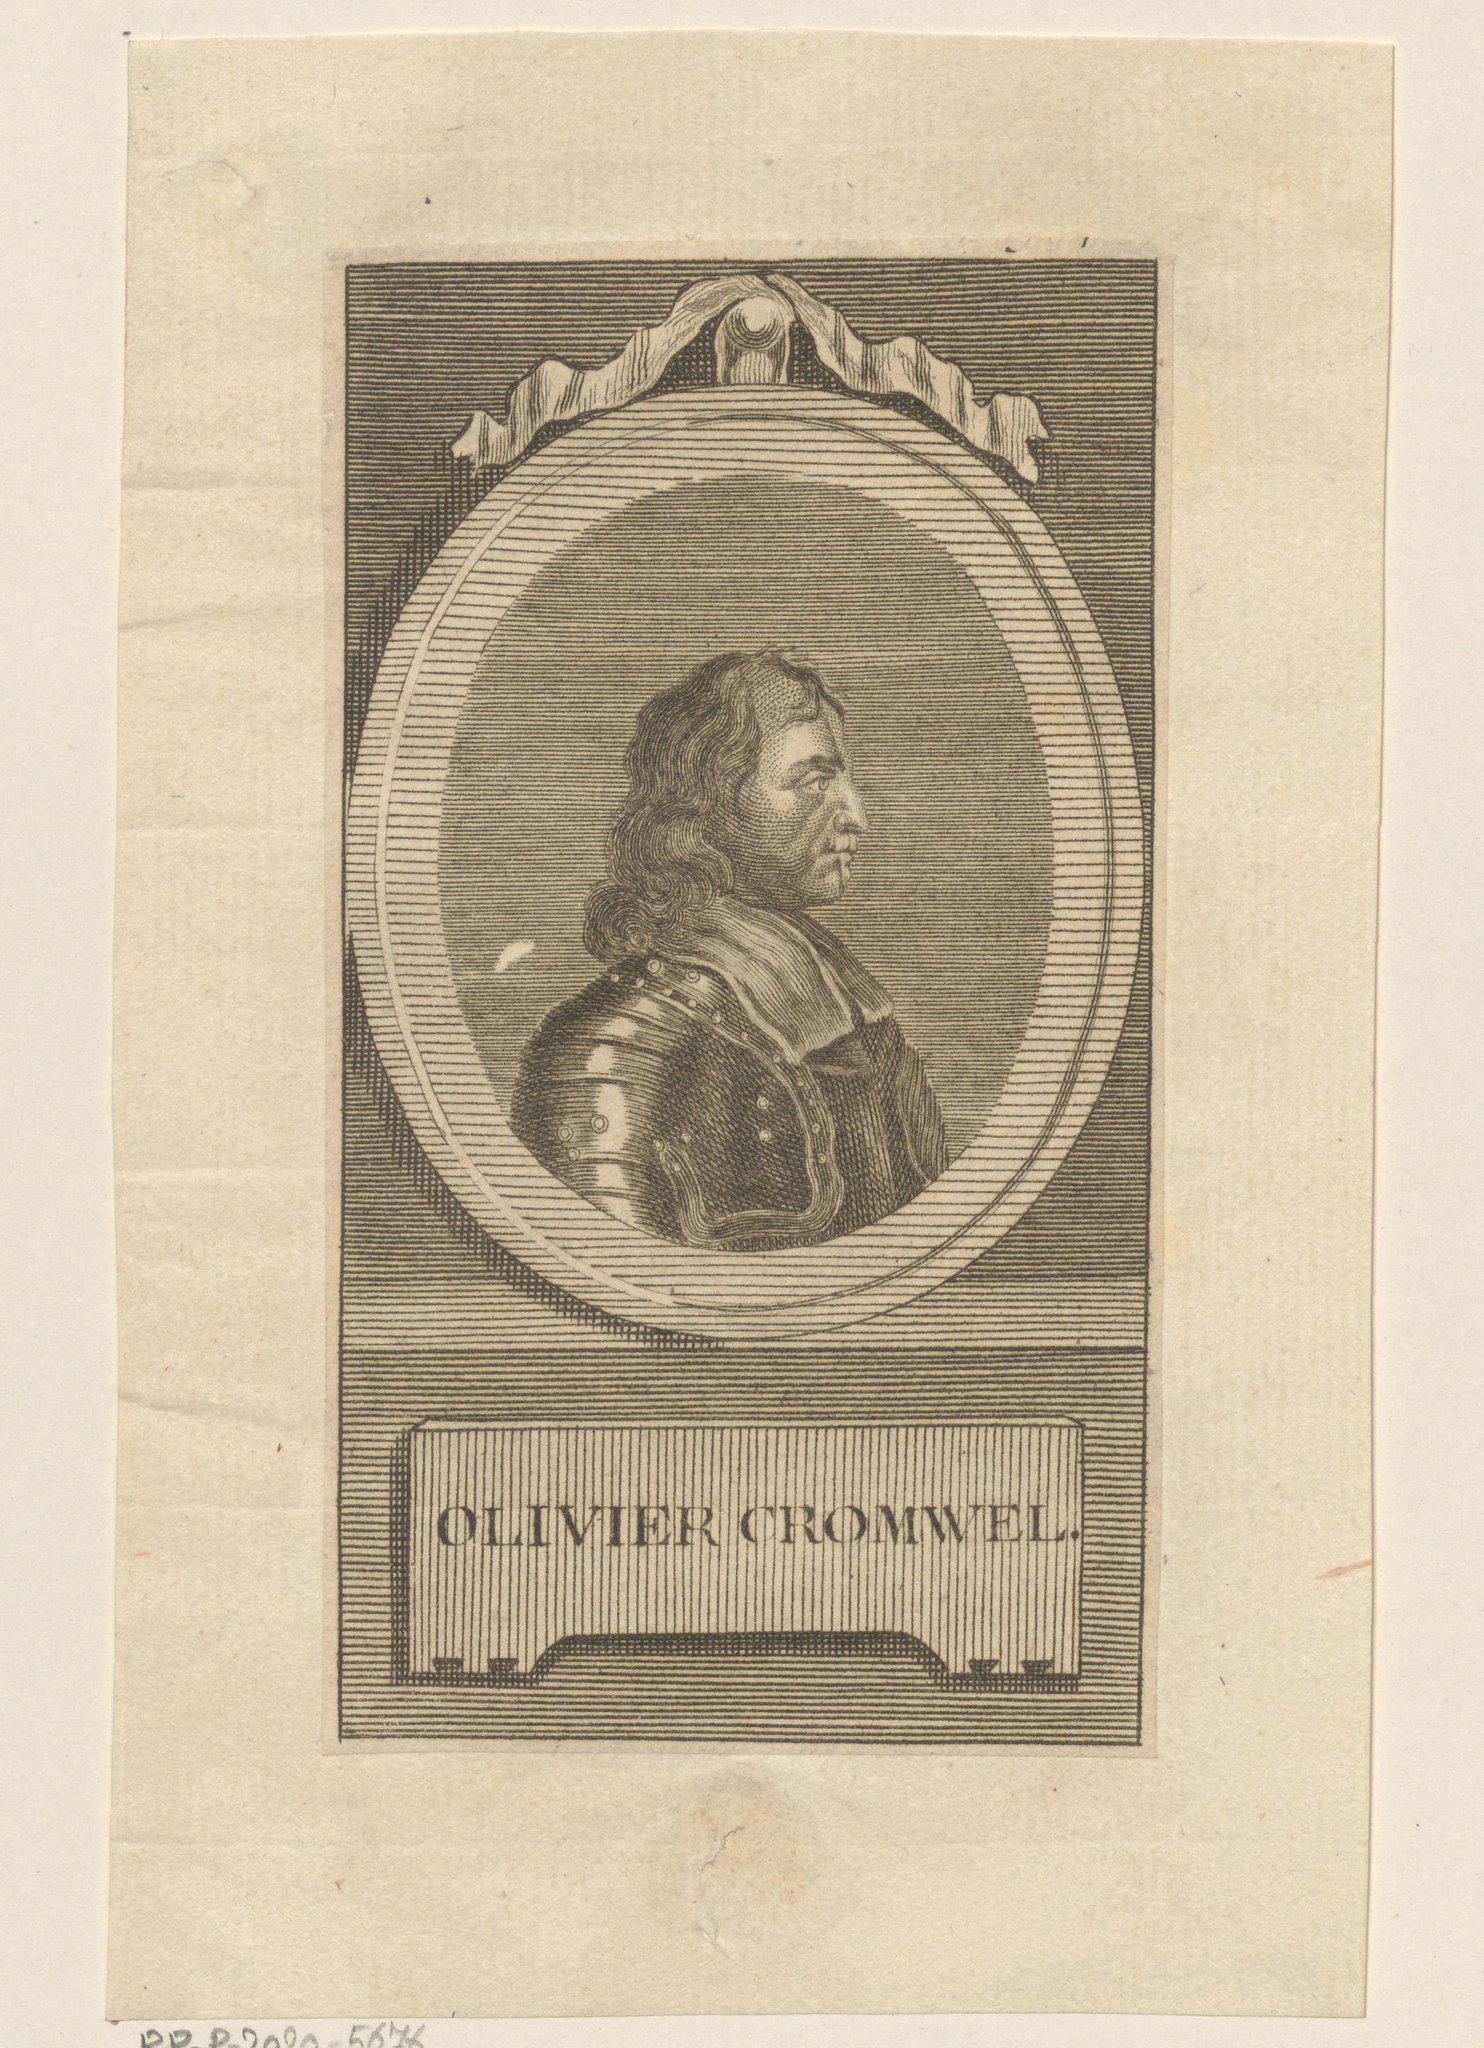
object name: print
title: Portret van Oliver Cromwell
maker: Anonymous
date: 1650-1749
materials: paper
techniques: engraving, etching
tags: oliver cromwell, historical persons